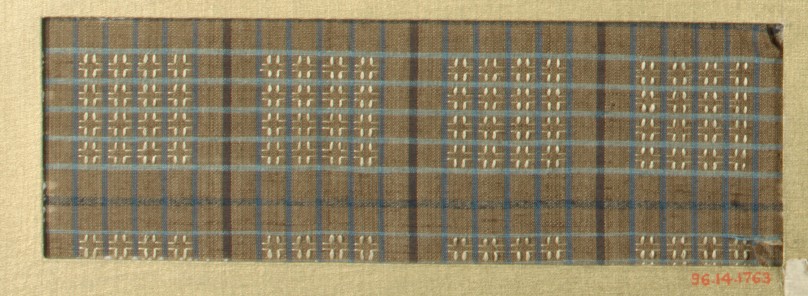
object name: piece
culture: japanese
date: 1701-1900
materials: silk